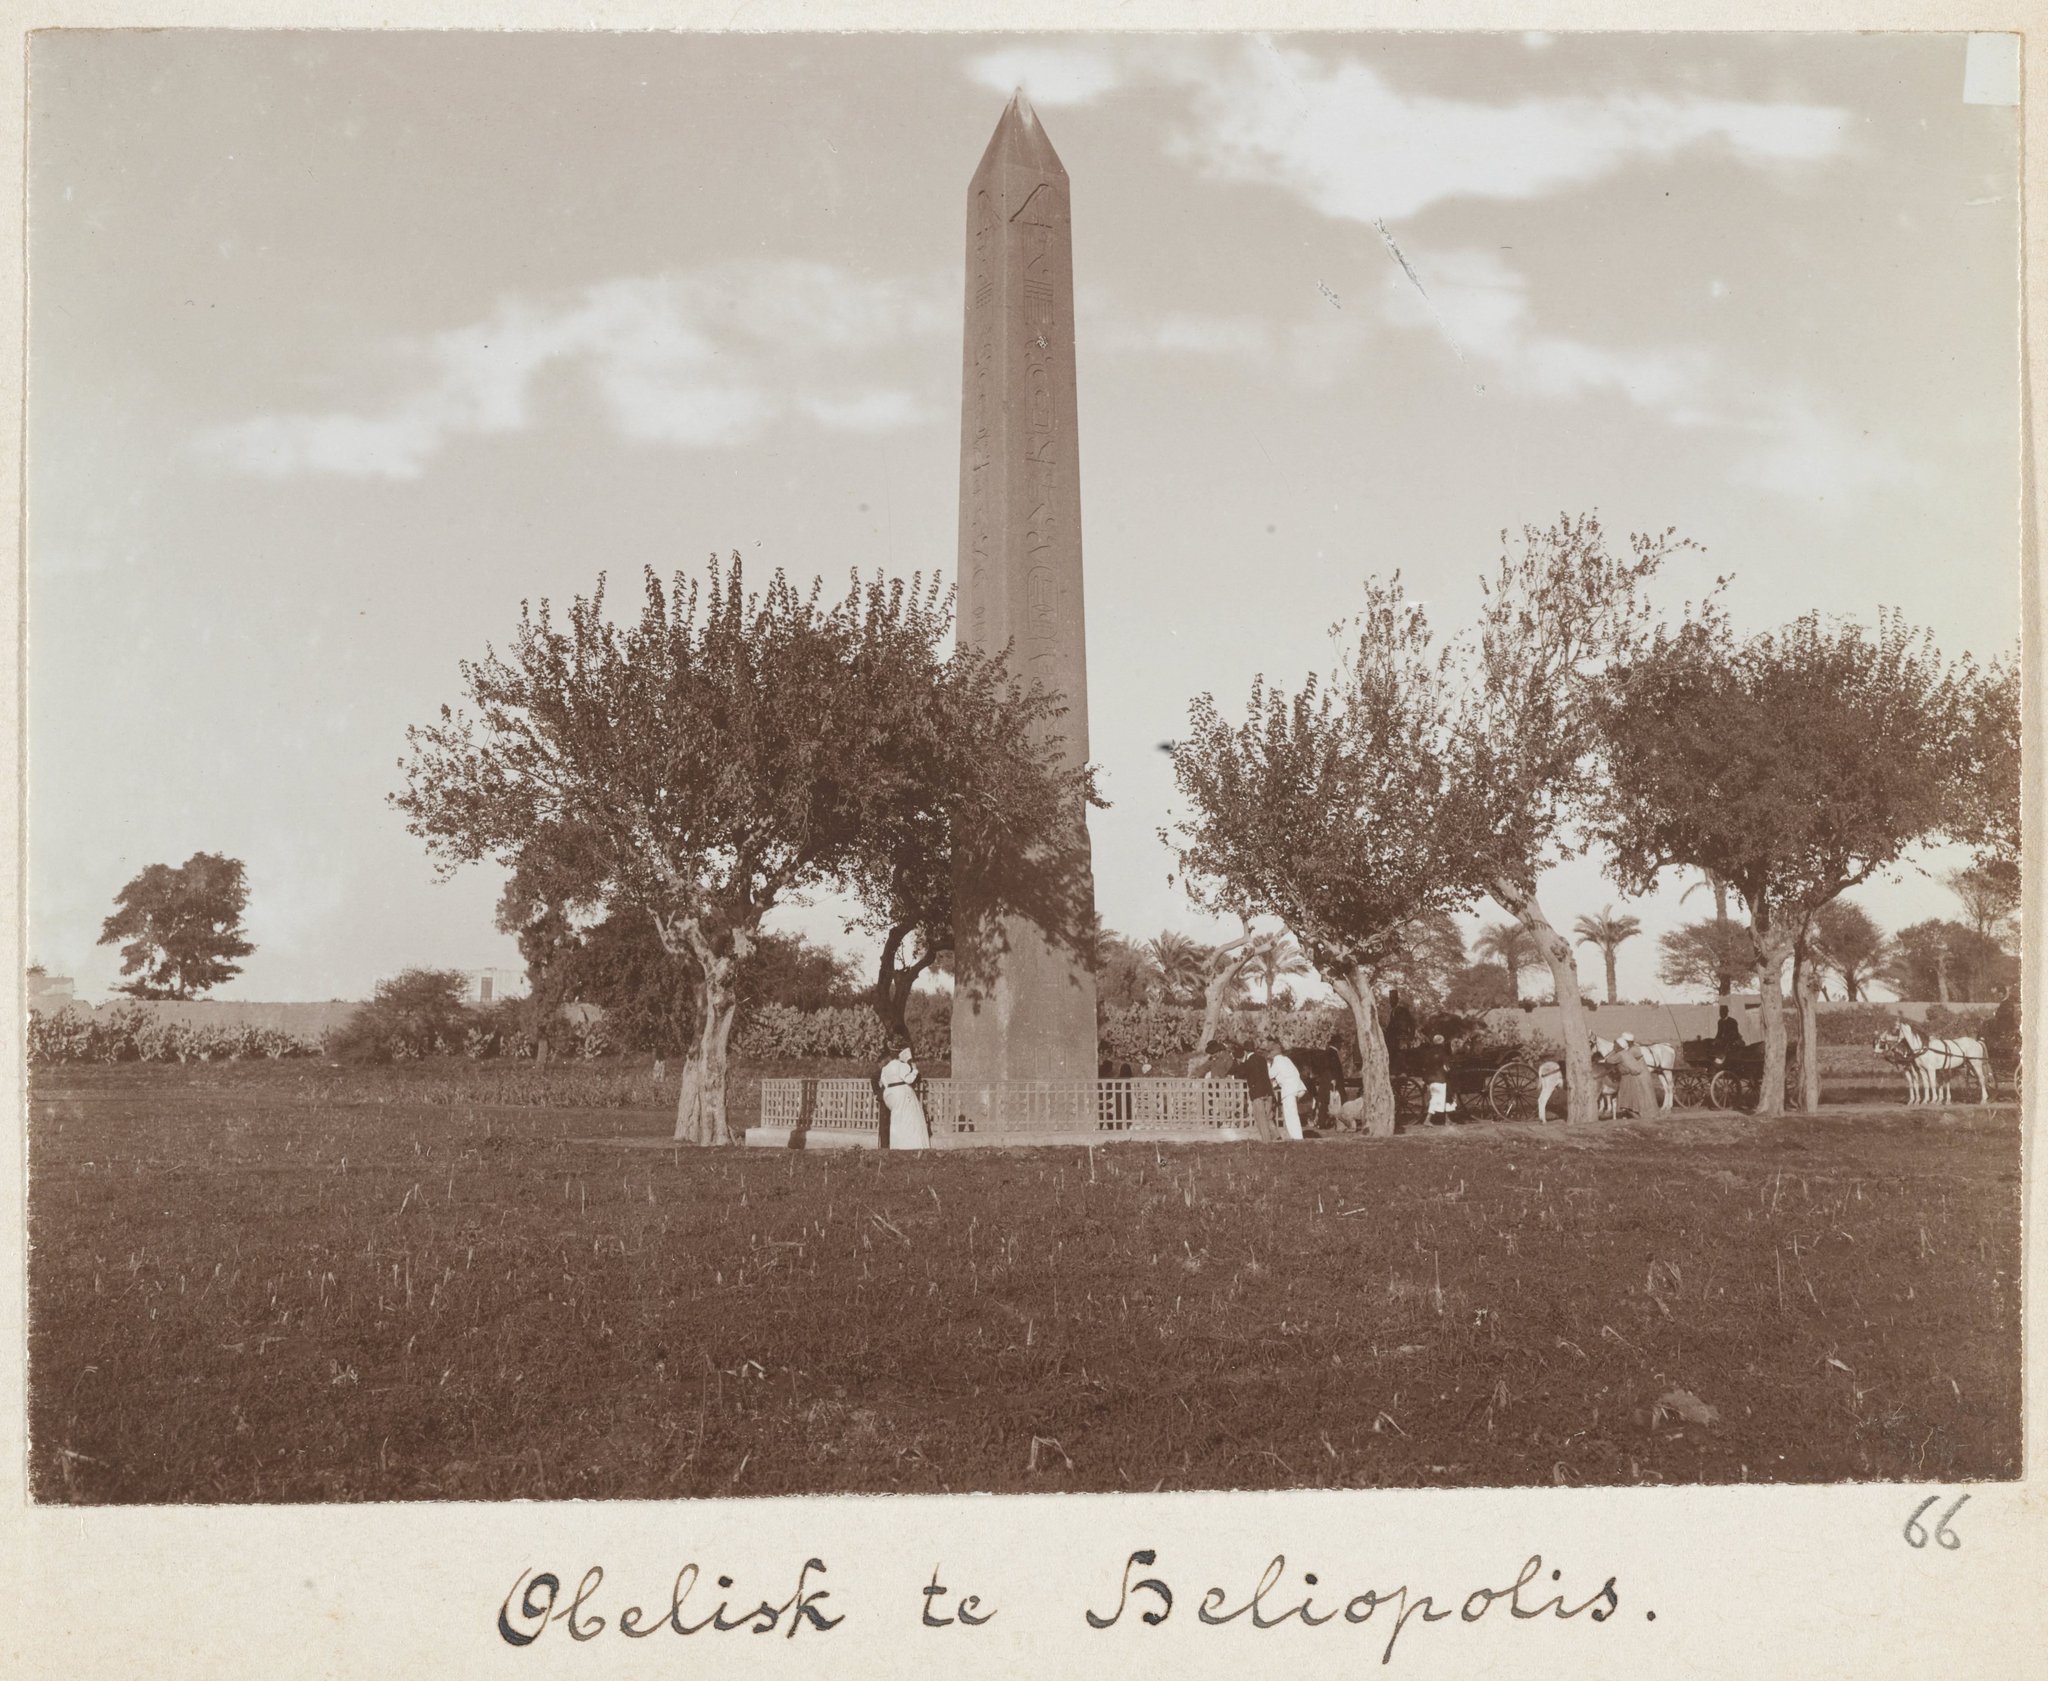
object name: photograph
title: Obelisk van Senoeseret I in voormalig Heliopolis (nu El Matareya) in Caïro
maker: johannes lodewijk heldring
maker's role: fotograaf, predikant, schrijver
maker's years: 1852-1923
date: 1898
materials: paper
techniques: collodion silver print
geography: cairo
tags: obelisk, needle